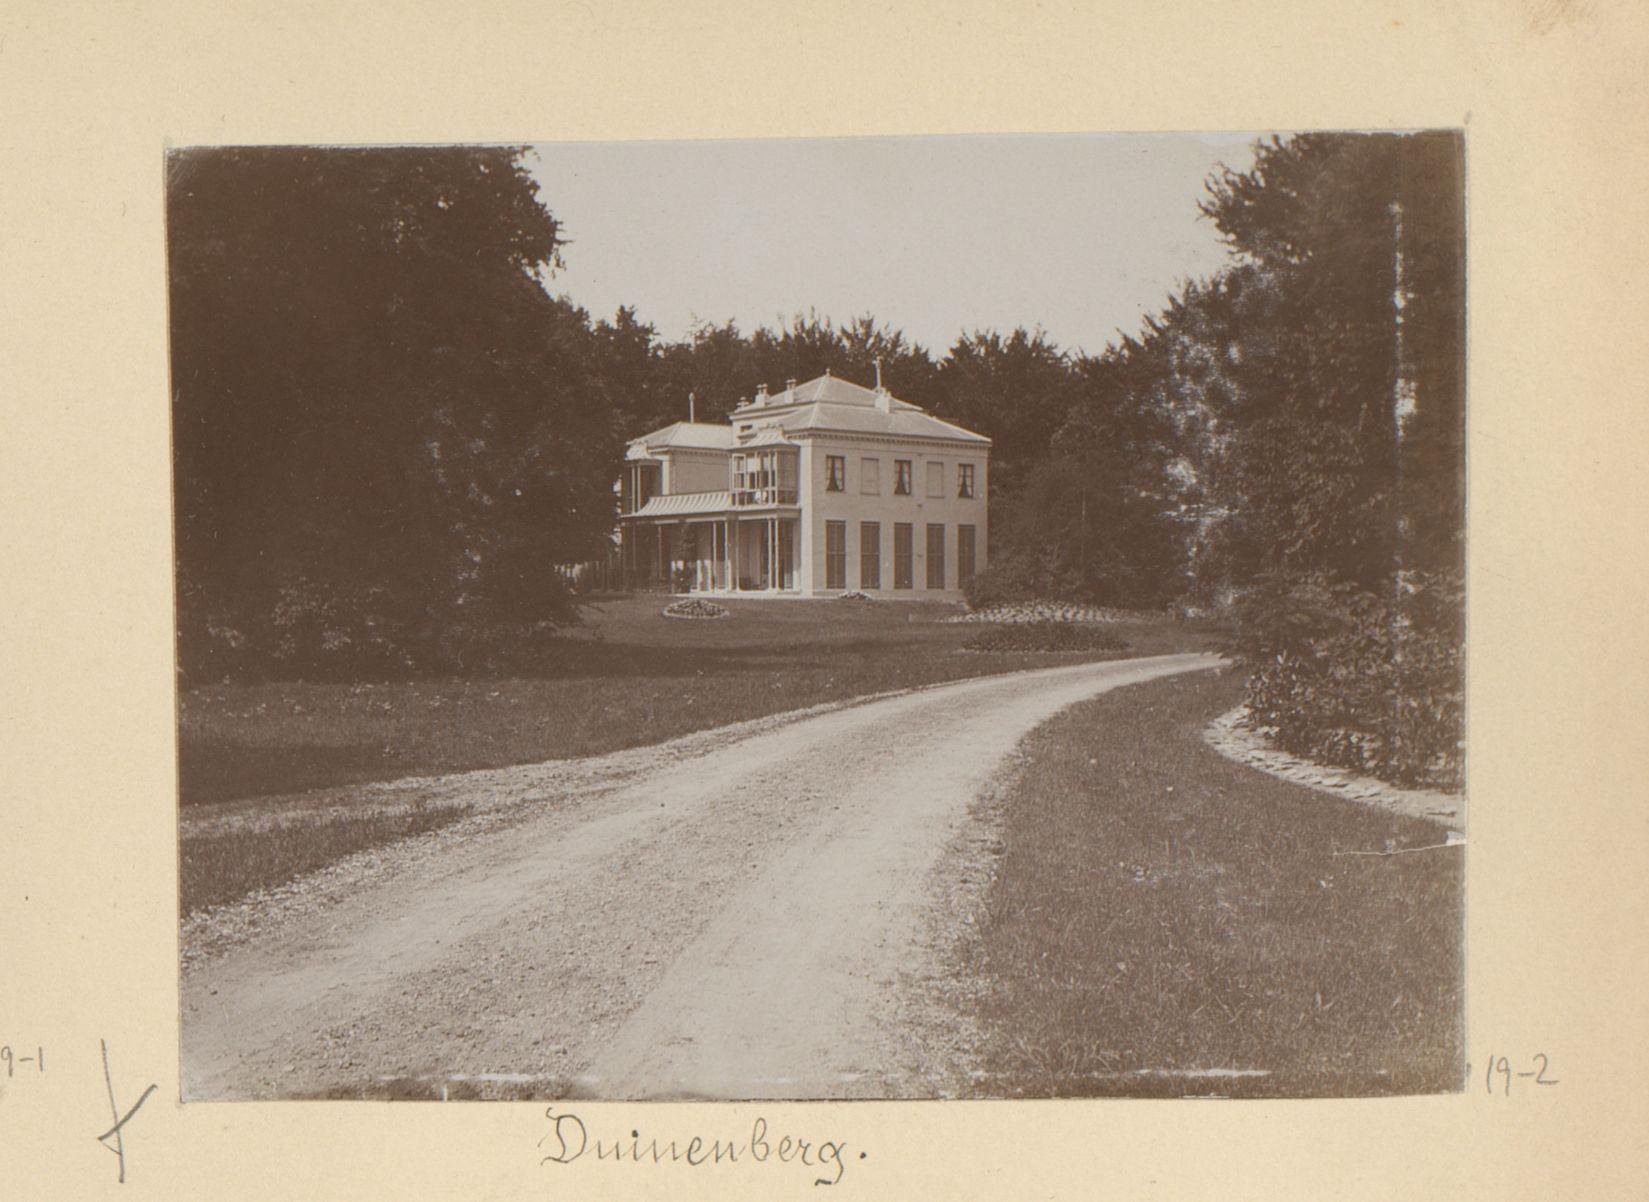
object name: album leaf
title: Gezicht op de voormalige buitenplaats Duinenberg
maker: hendrik herman van den berg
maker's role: amateurfotograaf, jurist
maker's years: 1875-1944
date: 1890-1894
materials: paper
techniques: collodion silver print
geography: velsen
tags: landscapes in the temperate zone, rural housing, e.g. country-house, villa, cottage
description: Foto 2 op albumblad 19 uit album "Amsterdam 1890-1894".